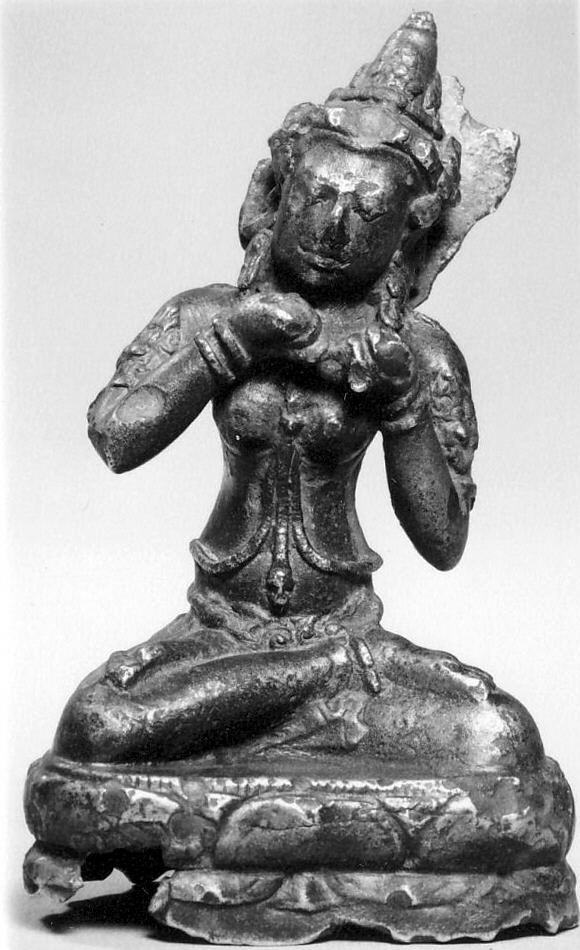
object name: figure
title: Seated Female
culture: indonesian, javanese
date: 967-1000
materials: brass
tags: women